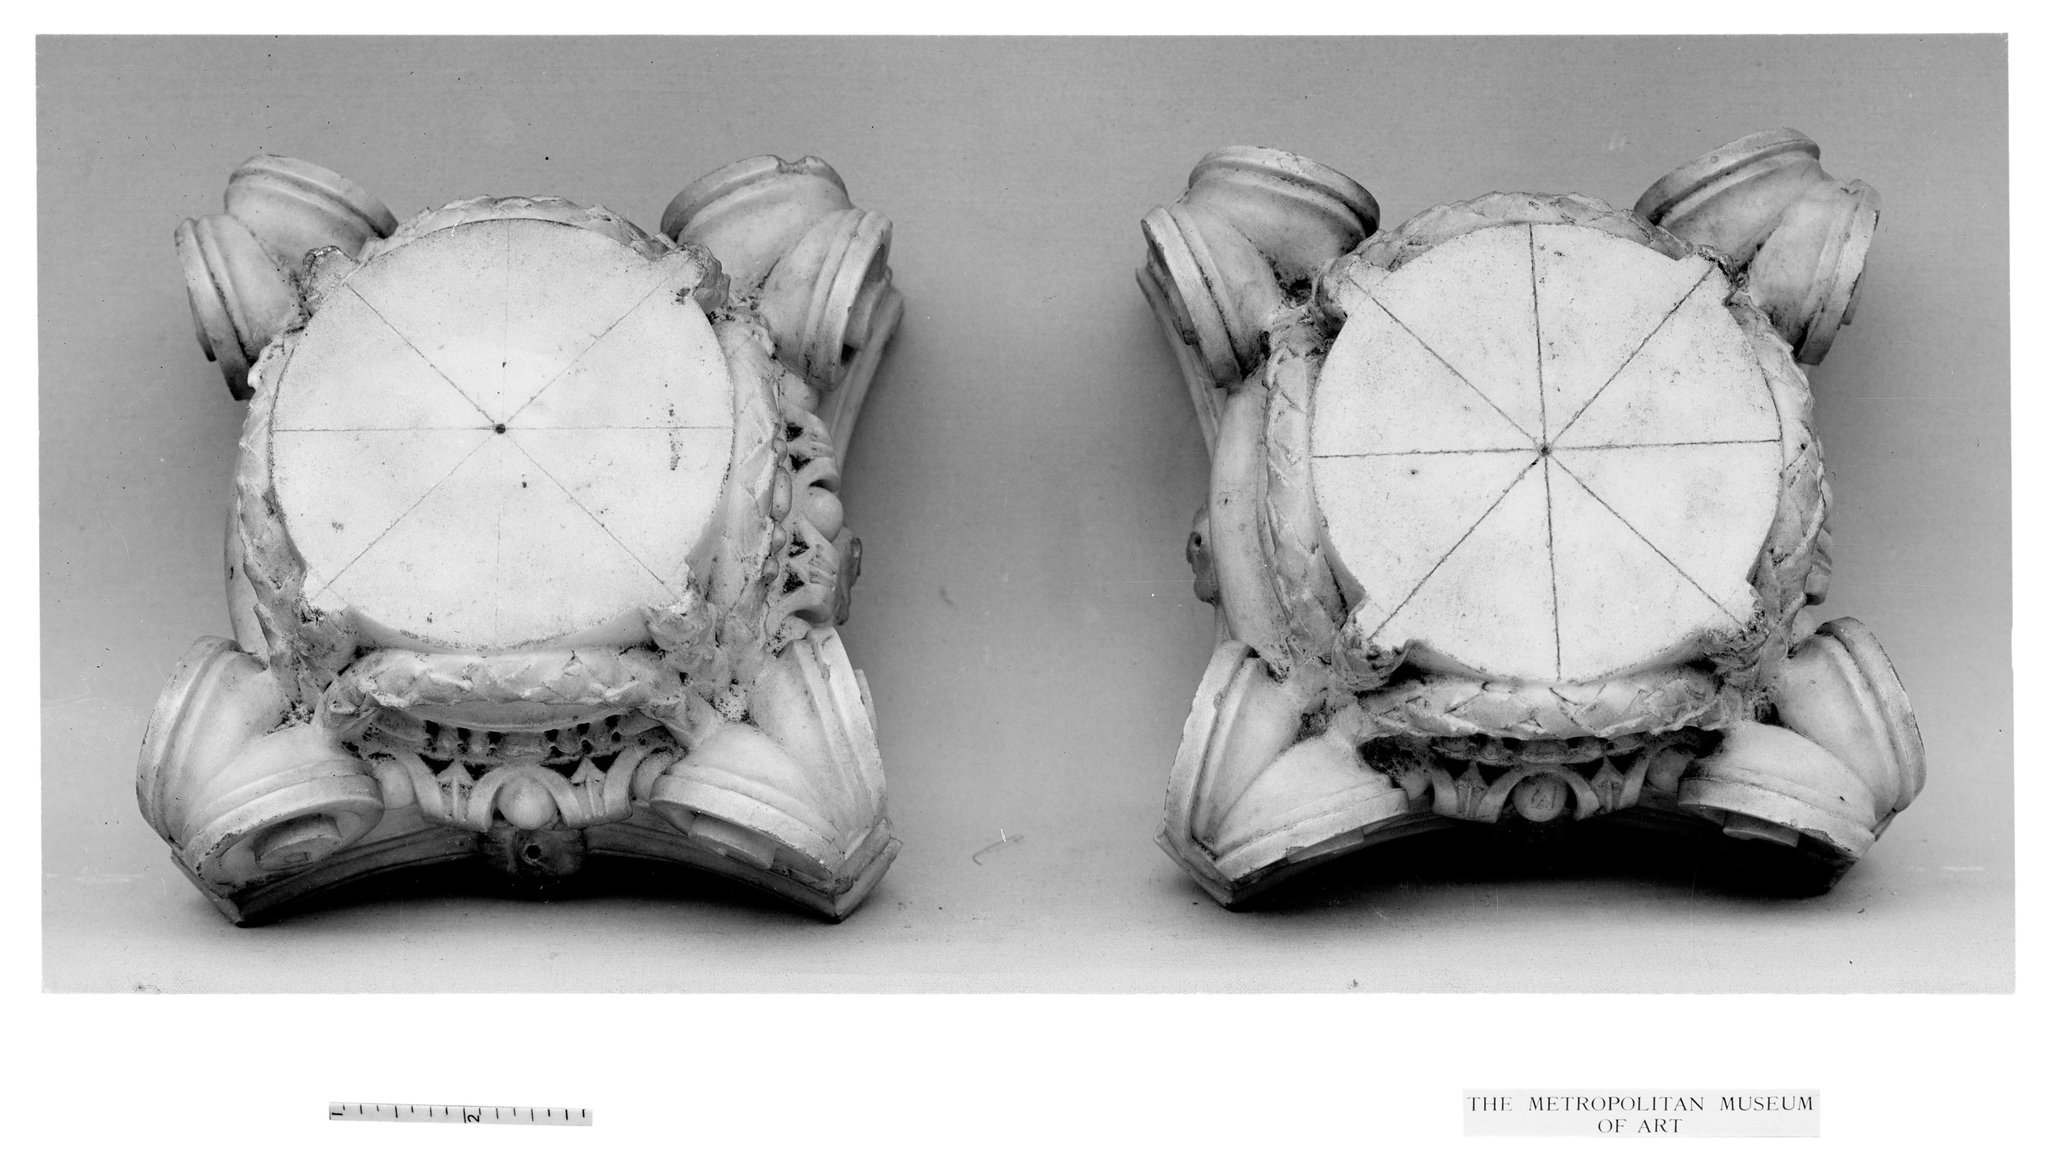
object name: capital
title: Capital (one of a pair)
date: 1701-1800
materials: marble